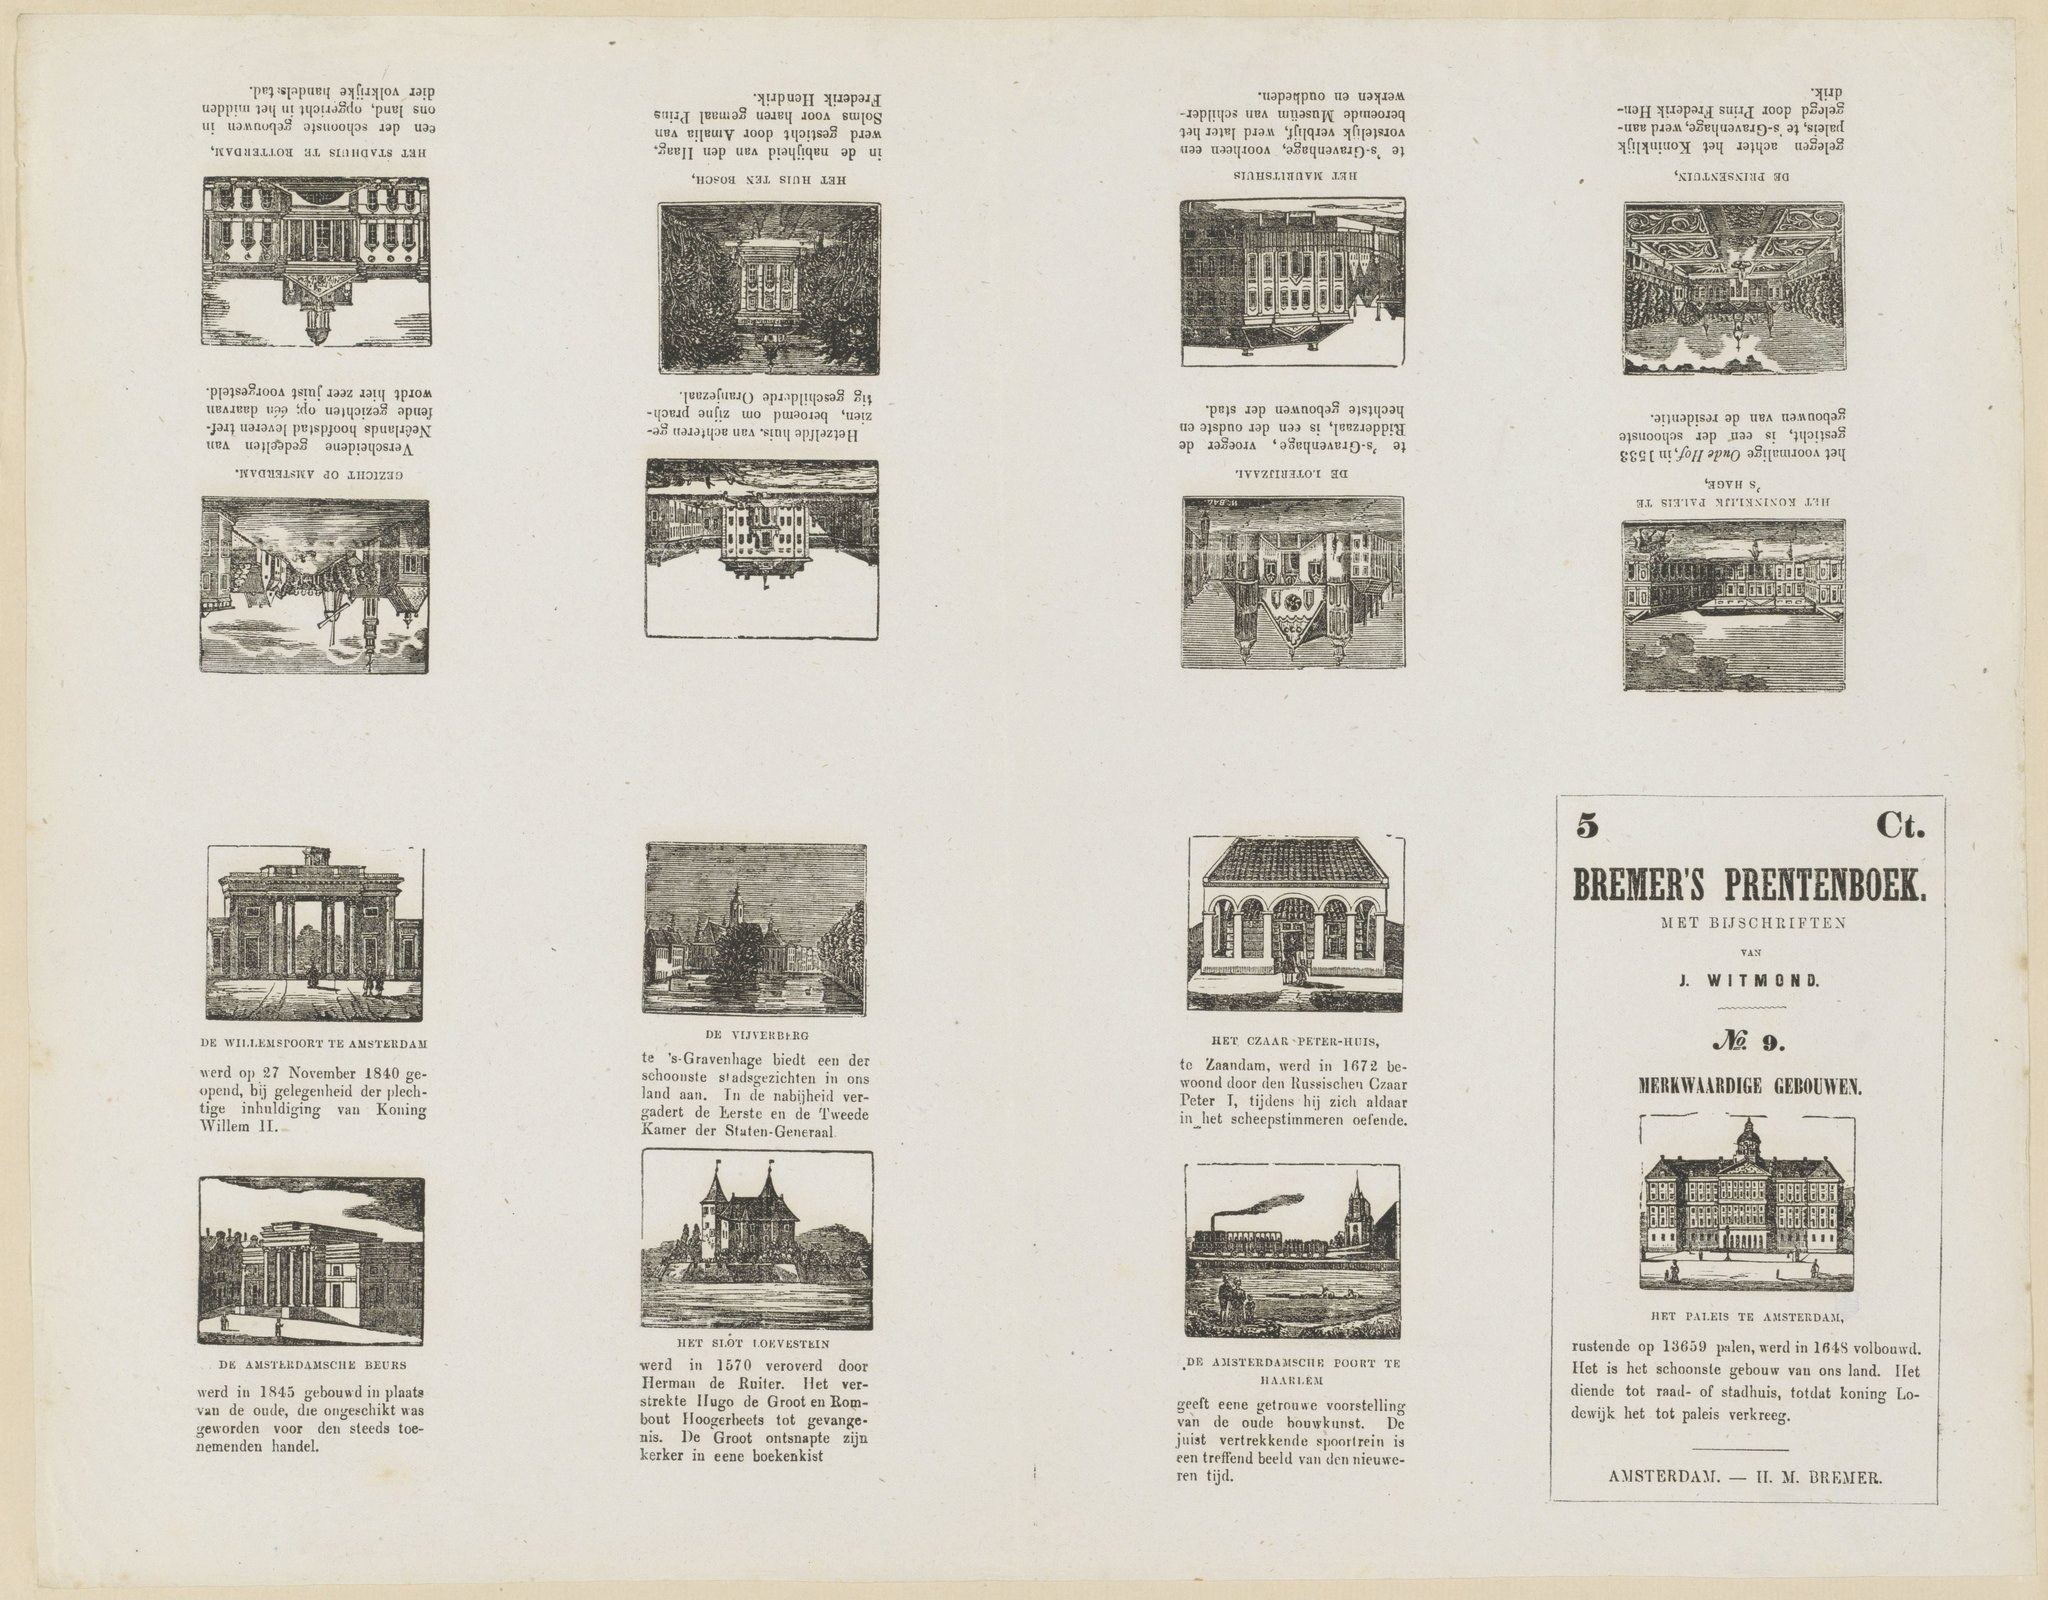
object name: popular print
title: Merkwaardige gebouwen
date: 1867-1883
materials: paper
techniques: letterpress printing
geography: delft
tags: palace, townhall, city-gate, loevestein castle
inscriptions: collector's mark: Lugt 2760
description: Blad met 14 voorstellingen van Nederlandse gebouwen, waaronder Slot Loevestein, het Mauritshuis en het Stadhuis te Rotterdam. Onder elke voorstelling de naam van het gebouw en drie tot vijf regels vers. Rechtsonder een blok met titels en uitgeversadres en een voorstelling van het paleis op de Dam te Amsterdam. Genummerd onder titel: No. 9.